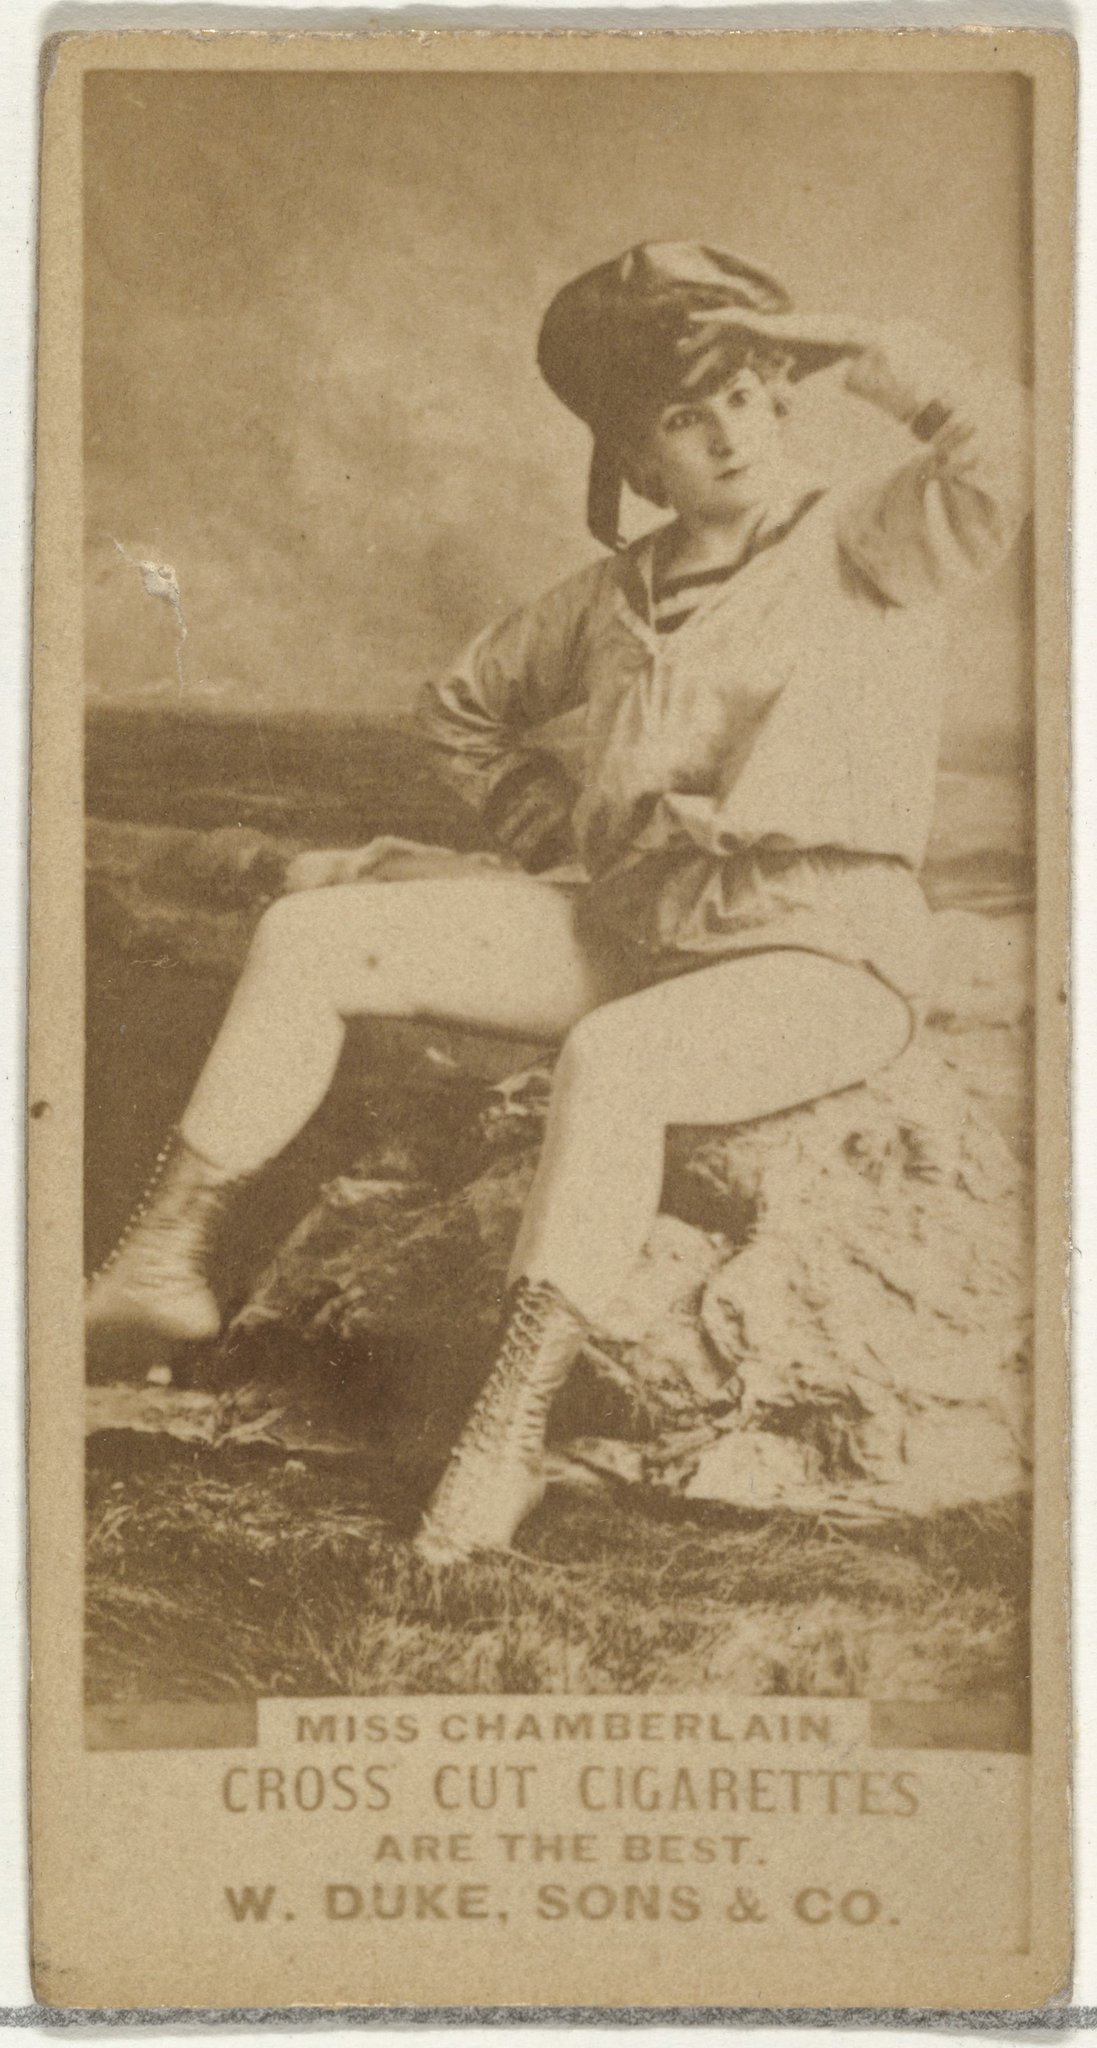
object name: photograph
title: Miss Chamberlain, from the Actors and Actresses series (N145-3) issued by Duke Sons & Co. to promote Cross Cut Cigarettes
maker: w. duke, sons & co.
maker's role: publisher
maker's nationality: american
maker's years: 1870-1920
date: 1880-1889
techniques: albumen silver print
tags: portraits,women,actresses